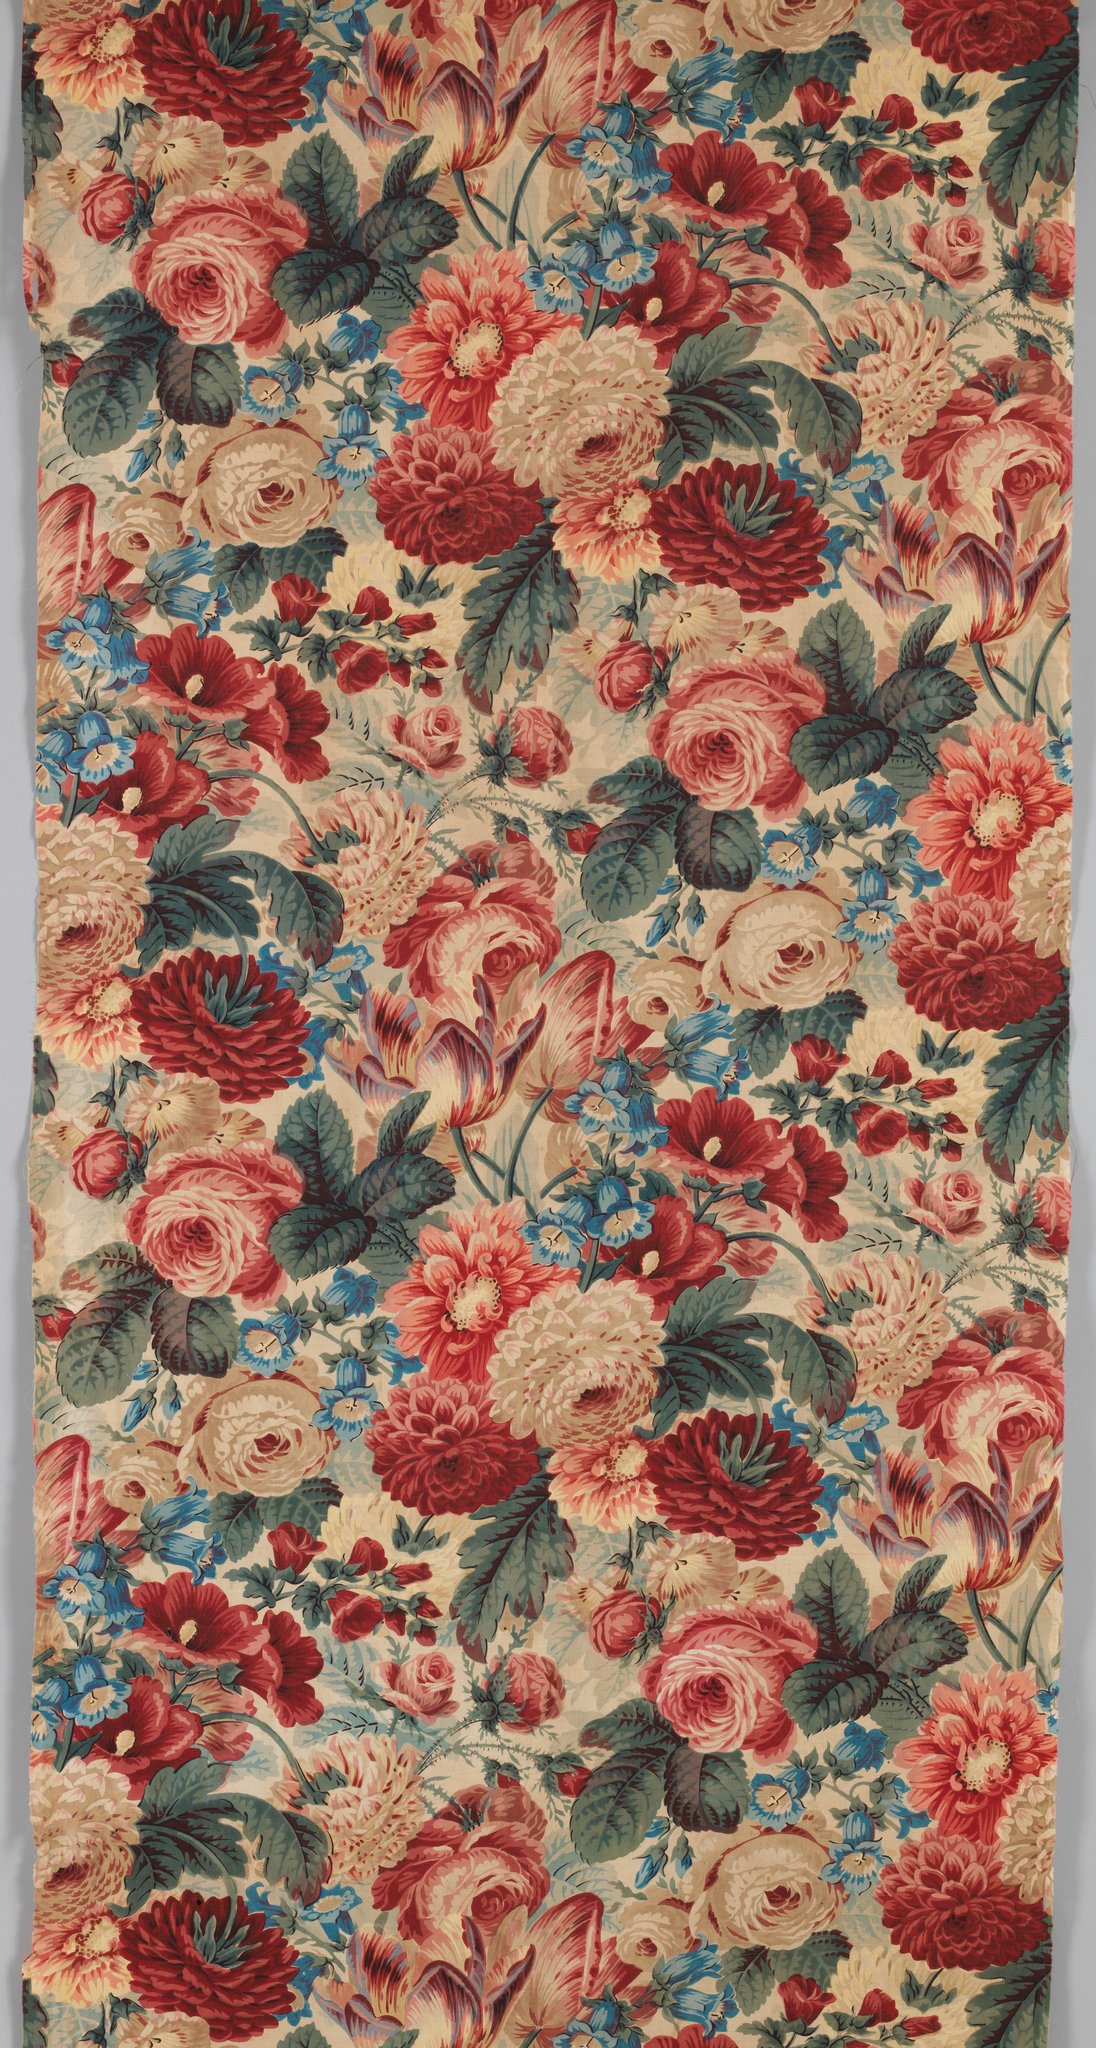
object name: piece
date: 1801-1900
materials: cotton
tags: flowers,leaves